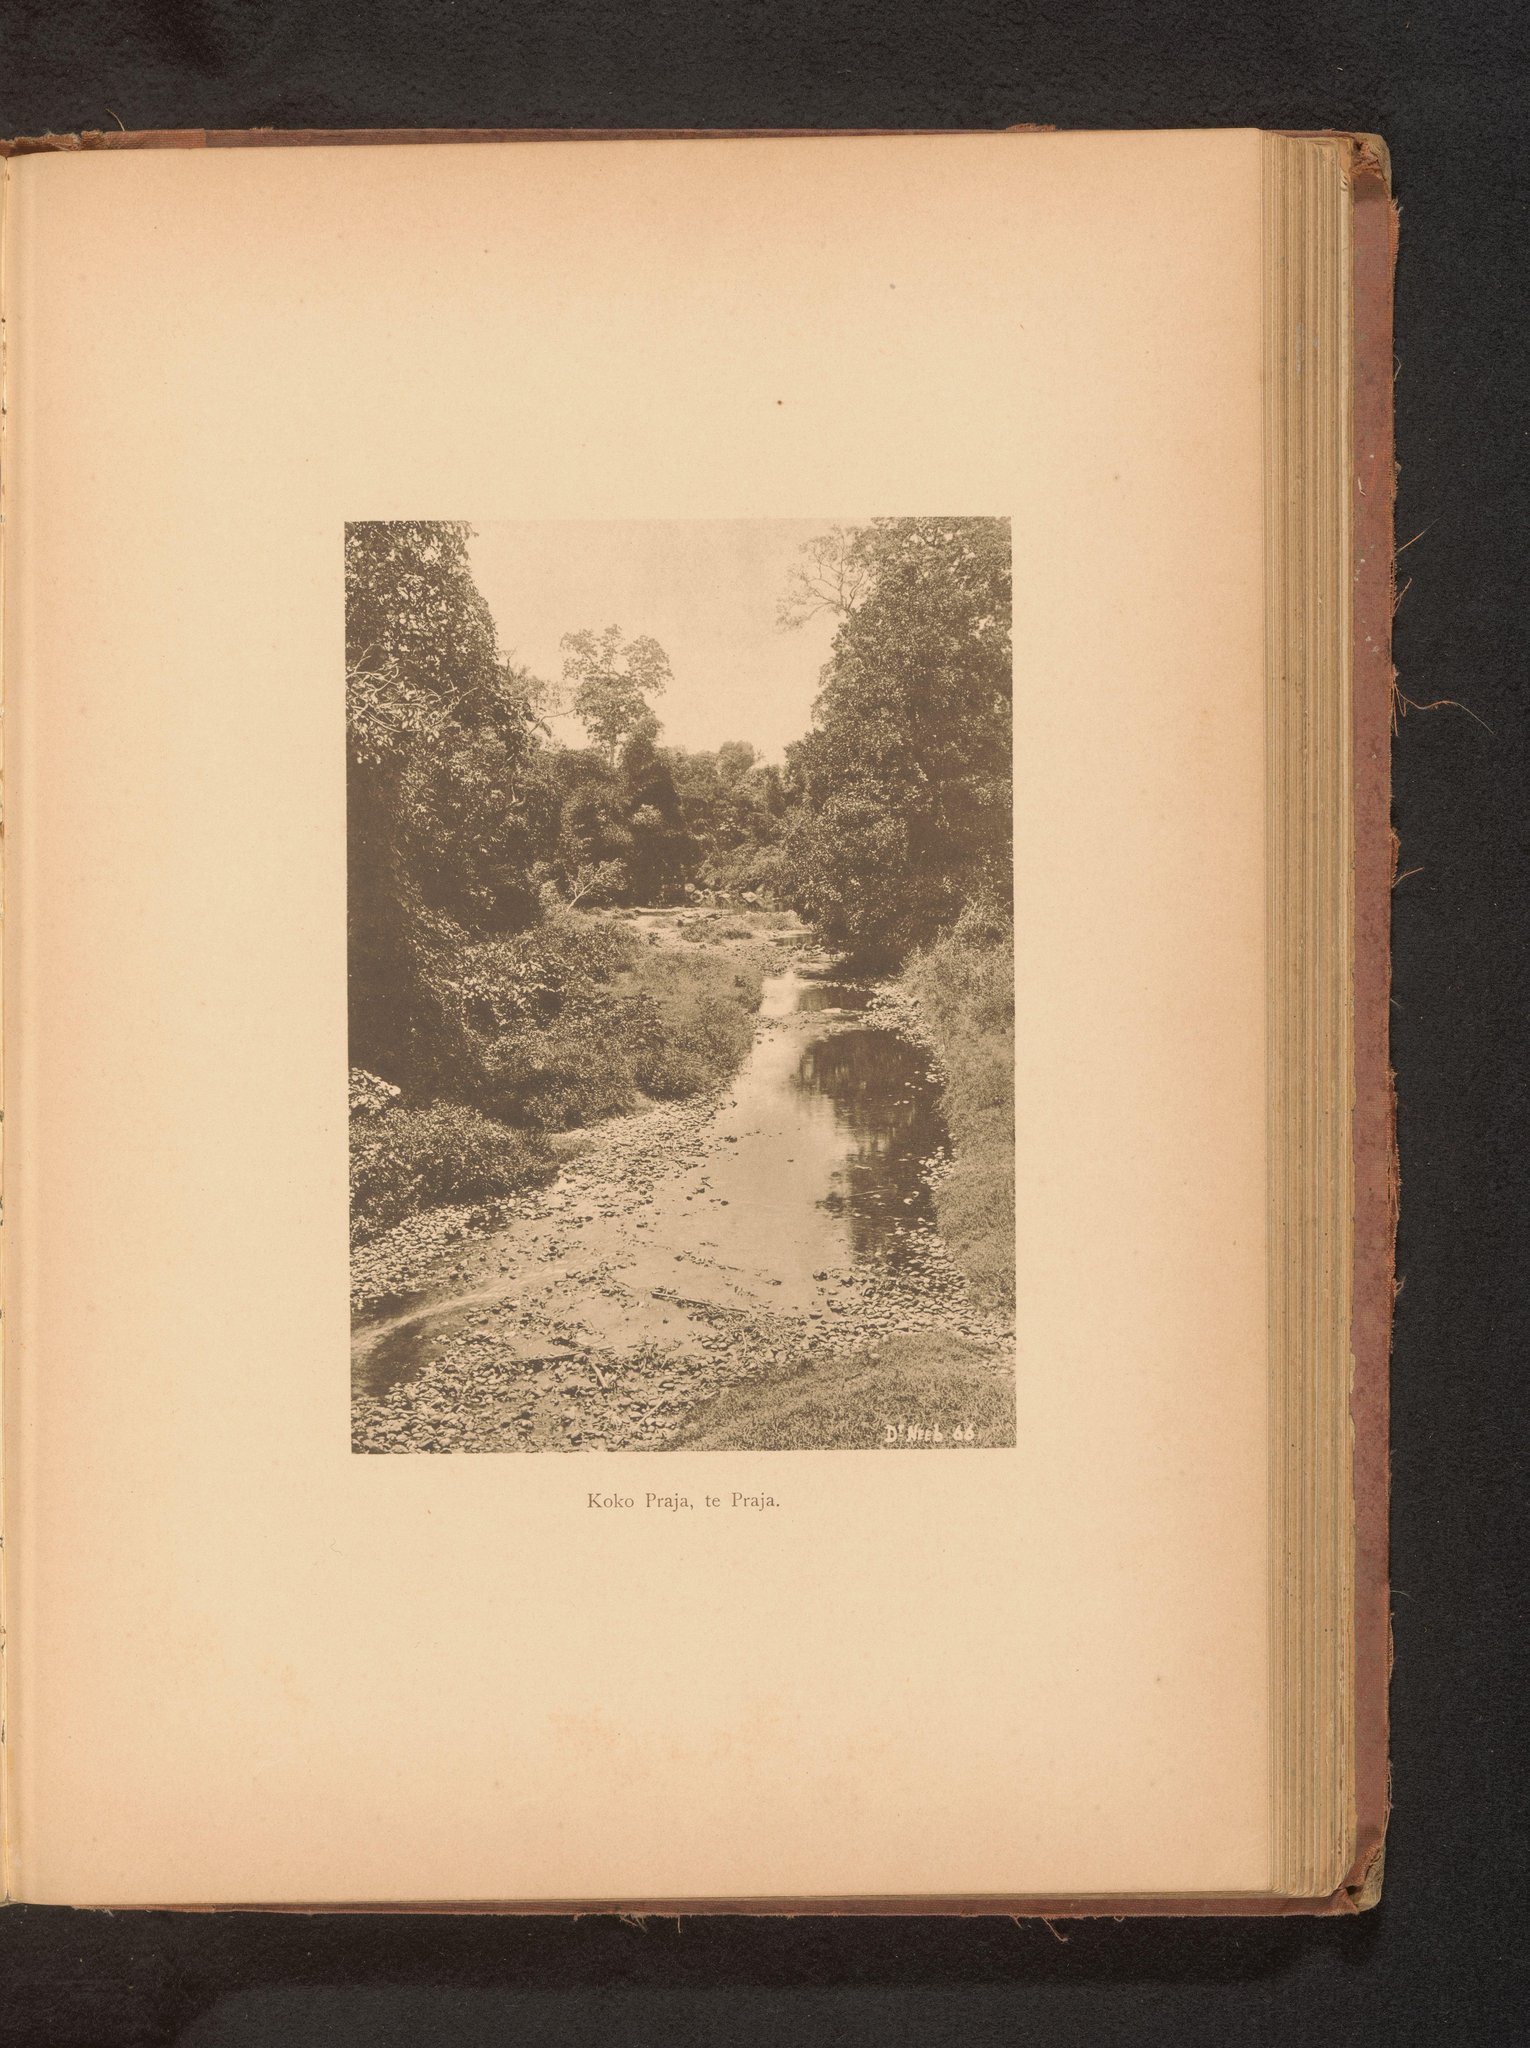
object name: photomechanical print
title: Gezicht op een rivier in een bebost gebied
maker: christiaan johan neeb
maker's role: arts, fotograaf, officier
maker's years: 1860-1925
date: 1892-1897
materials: paper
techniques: photograph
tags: trees, river, indonesia